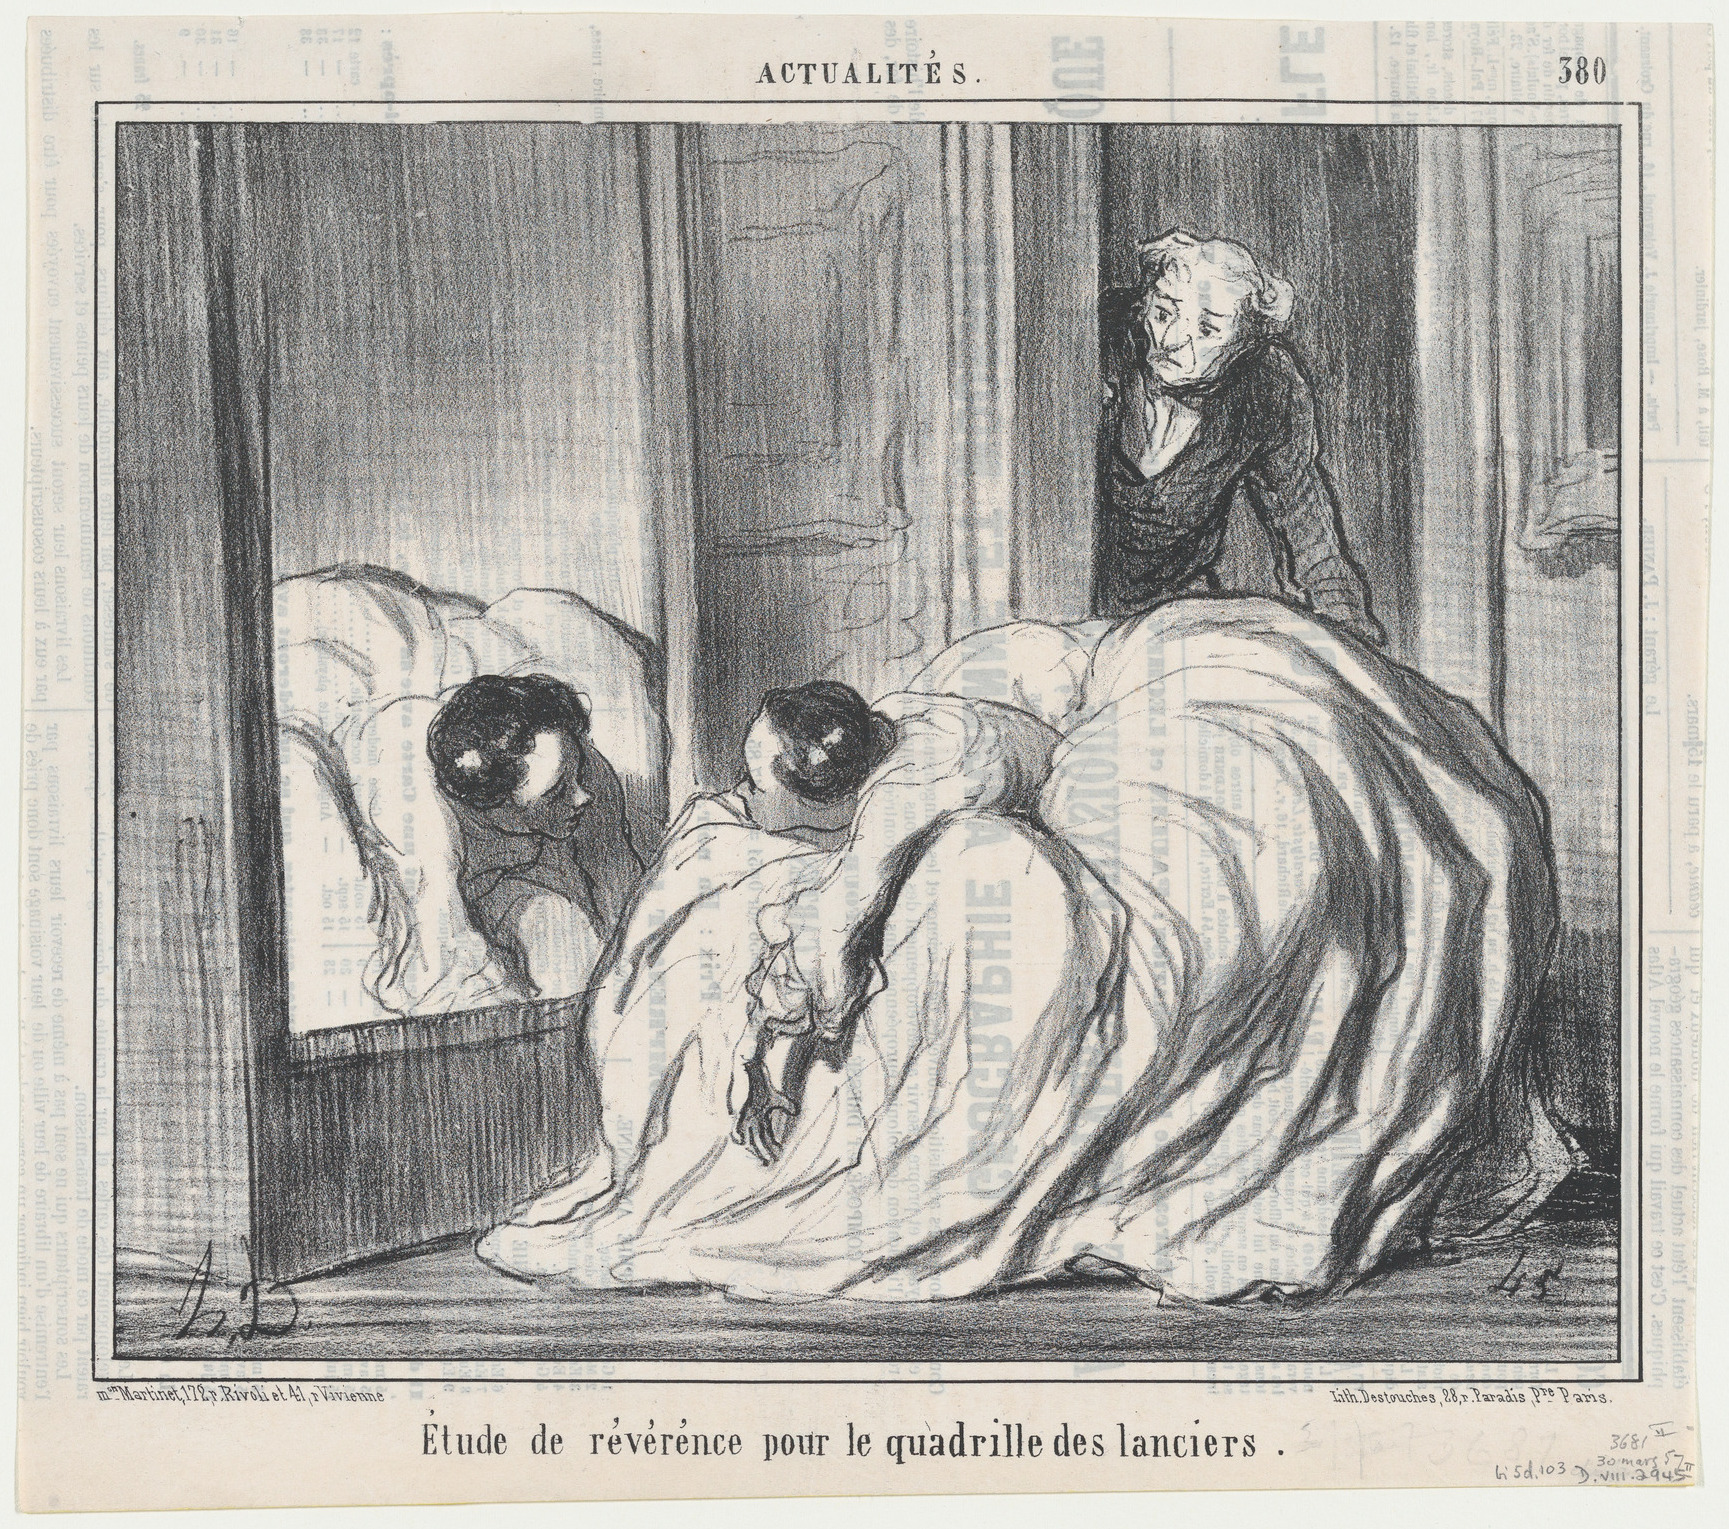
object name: print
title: Étude de révérence pour le quadrille des lanciers, from Actualités, publlished in Le Charivari, March 30, 1857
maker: honoré daumier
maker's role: artist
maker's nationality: french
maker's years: 1808-1879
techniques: lithograph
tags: men,women,mirrors